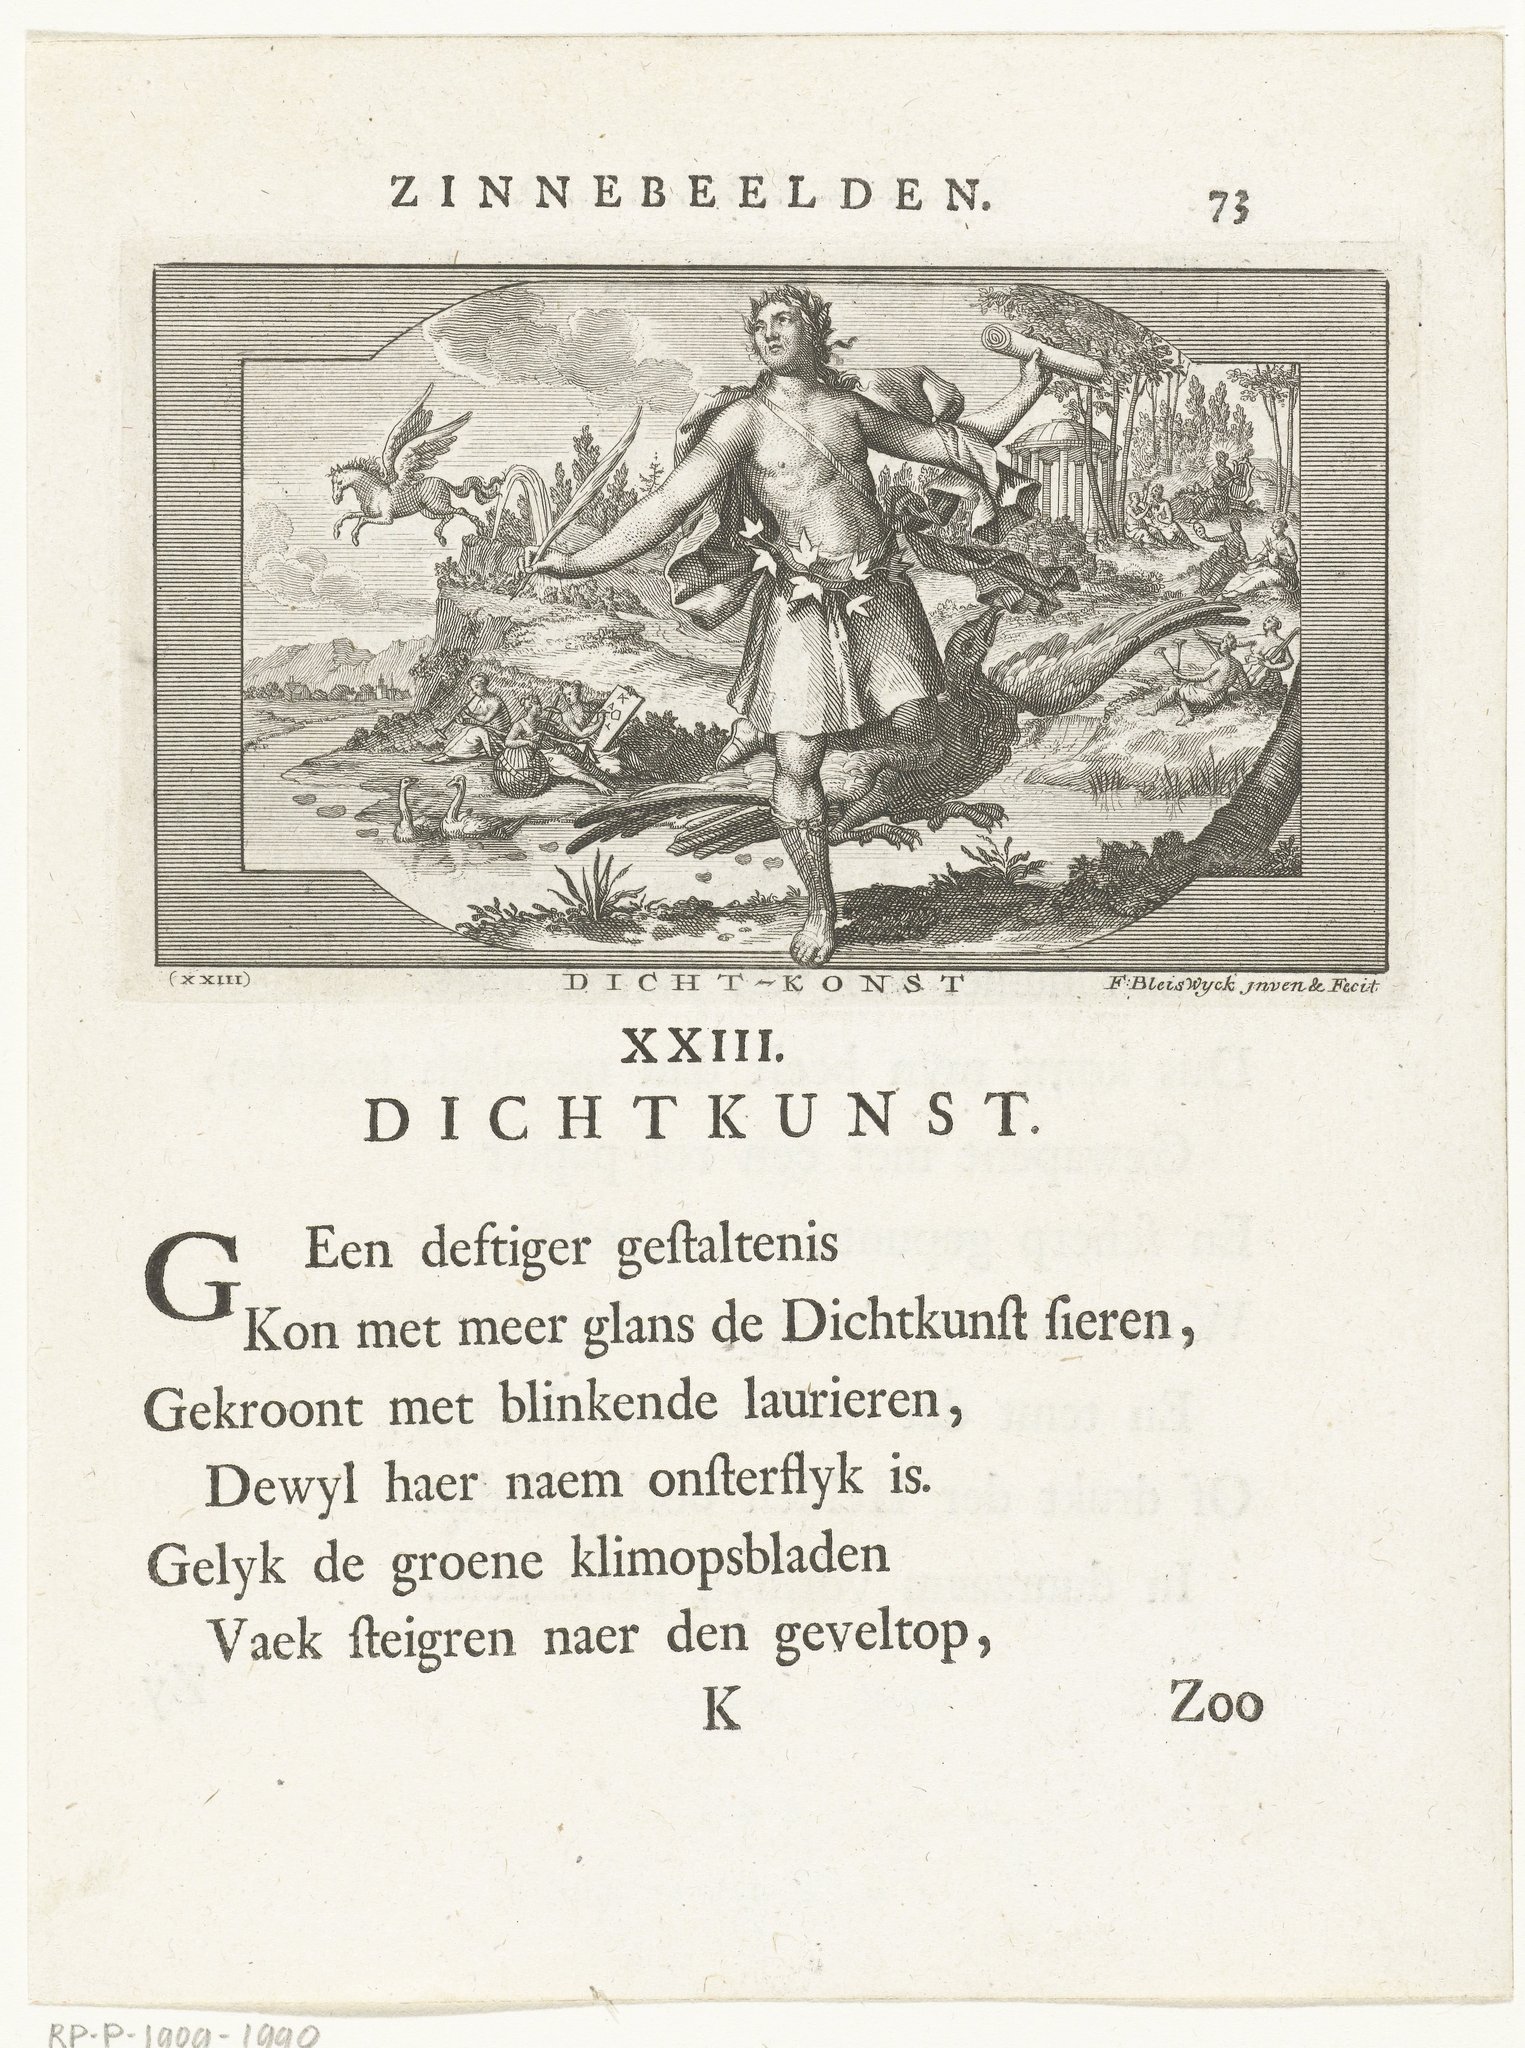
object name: book illustration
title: Dicht-konst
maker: françois van bleyswijck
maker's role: draughtsman, print maker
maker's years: 1671-1746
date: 1681-1737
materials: paper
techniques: etching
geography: leiden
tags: pegasus, the winged horse, apollo and the muses, apollo musagetes, predatory birds: eagle, parnassus, sacred to apollo musagetes, symbolic representations, allegories and emblems ~ poetry; 'poesia' (ripa)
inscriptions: collector's mark: Lugt 2228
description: Embleem met allegorie op dichtkunst verbeeld als man met papierrol en pen en lauwerkrans op zijn hoofd. De adelaar illustreert de vlucht die de dichtkunst bij de dichter kan nemen aldus het gedicht onder de voorstelling. In het landschap zitten de muzen op de berg Parnassus en speelt Apollo op zijn harp terwijl Pegasus voorbij vliegt. Het gedicht wordt vervolgd op het verso.